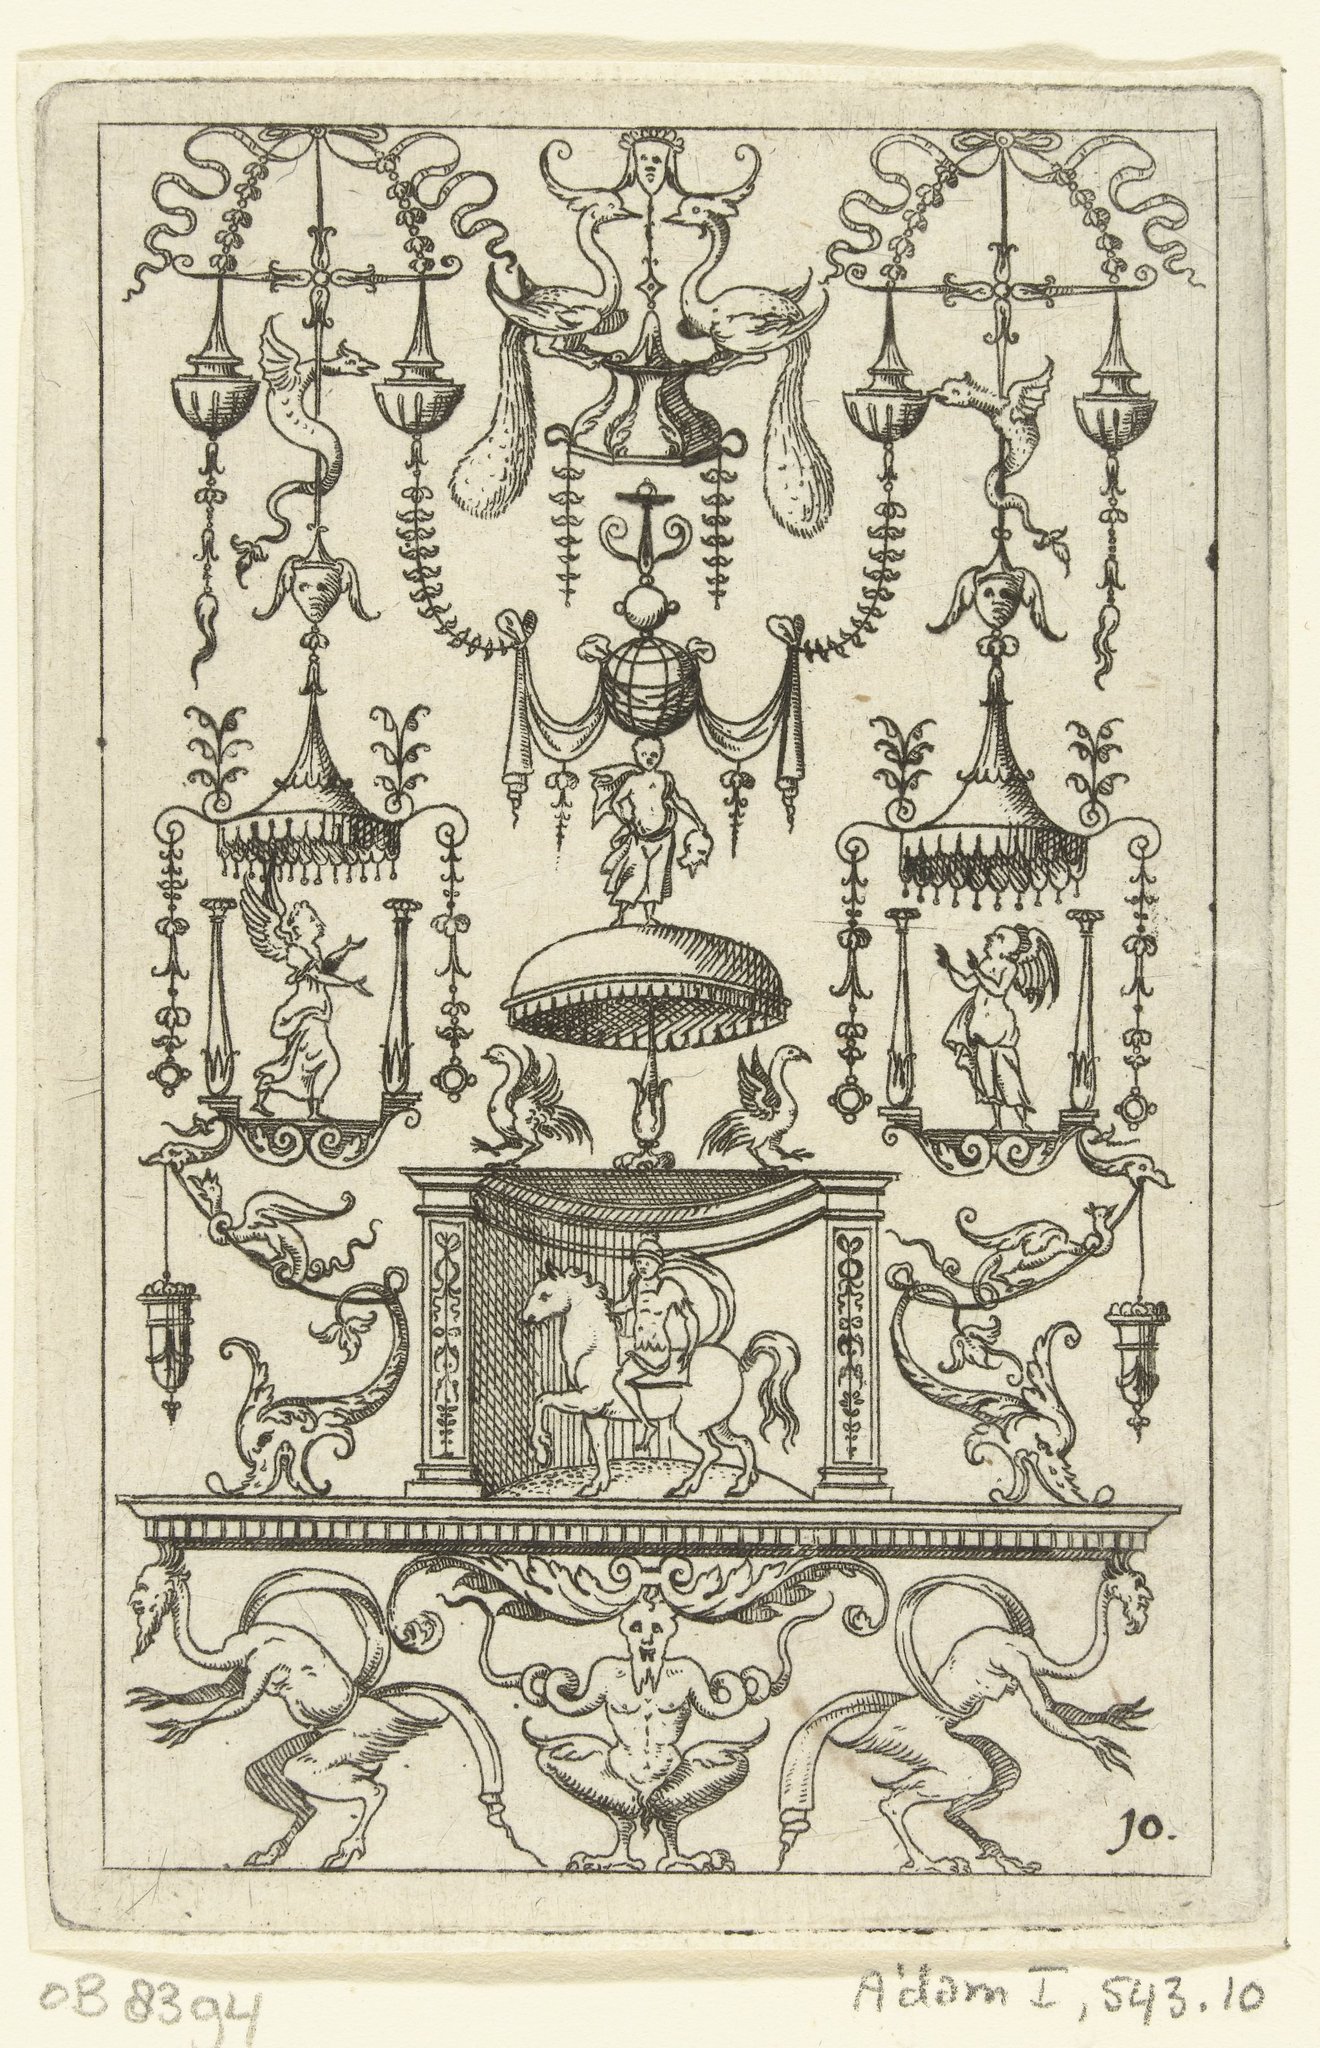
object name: ornament print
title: Iacobus Androuetius Du Cerceau inventor ante annos non paucos conscripsit (...)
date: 1525-1594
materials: paper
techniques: etching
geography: france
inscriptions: collector's mark: Lugt 240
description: Blad uit serie met architectuurfantasieën en grotesken met fabelwezens, guirlandes, kandelabers en mascarons.